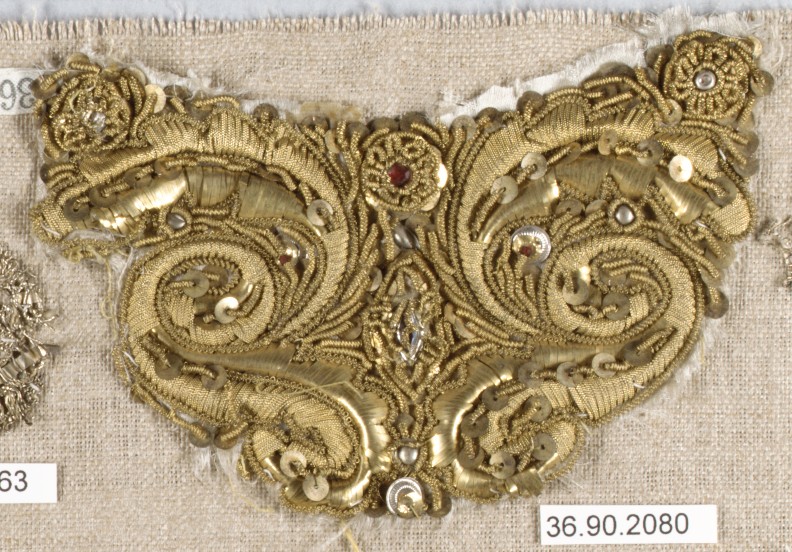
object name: passementerie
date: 1801-1900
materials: silk